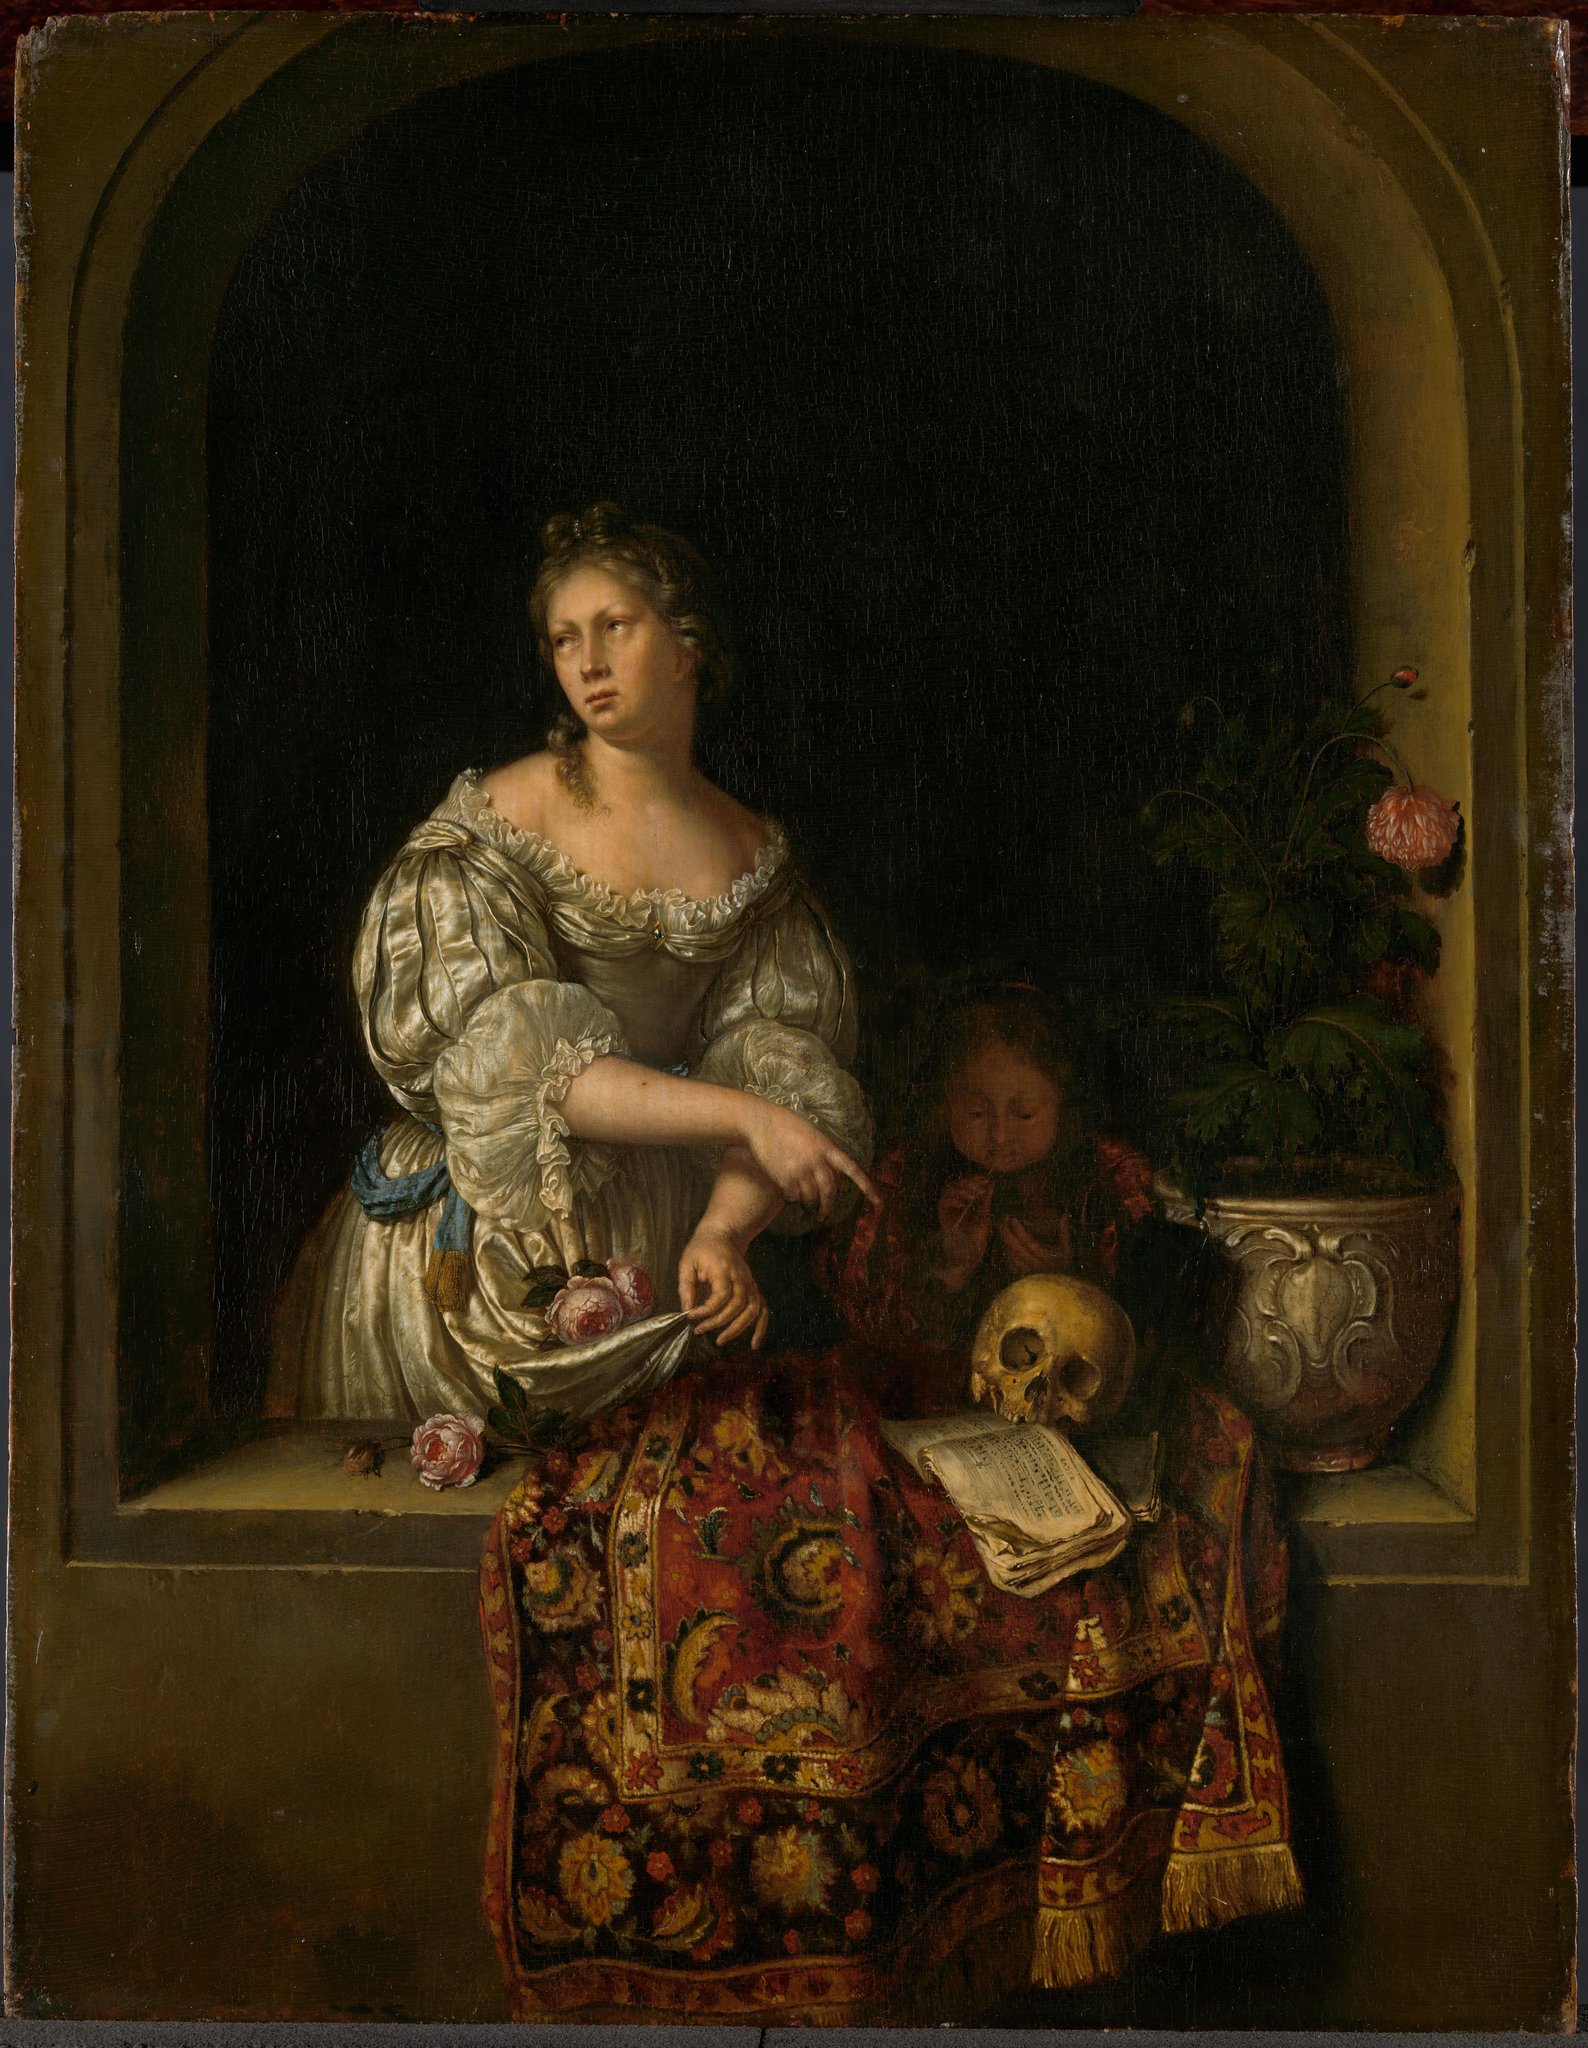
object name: painting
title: Allegory of Transience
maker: willem van mieris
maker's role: draughtsman, painter, print maker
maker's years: 1662-1747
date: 1670-1681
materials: oil, panel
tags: scenes symbolizing 'vanitas', skull as symbol of 'vanitas', printed edition of musical score, (children or putti) blowing bubbles, 'homo bulla' ~ scene symbolizing 'vanitas'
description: Allegorie op de vergankelijkheid. Een staande jonge vrouw in een venster wijst naar een schedel en een muziekboek die op een Perzisch kleed op de vensterbank liggen. Rechts een papaver in een pot. De vrouw houdt bloemen in haar schort. Achter de vrouw blaast een jongen bellen.